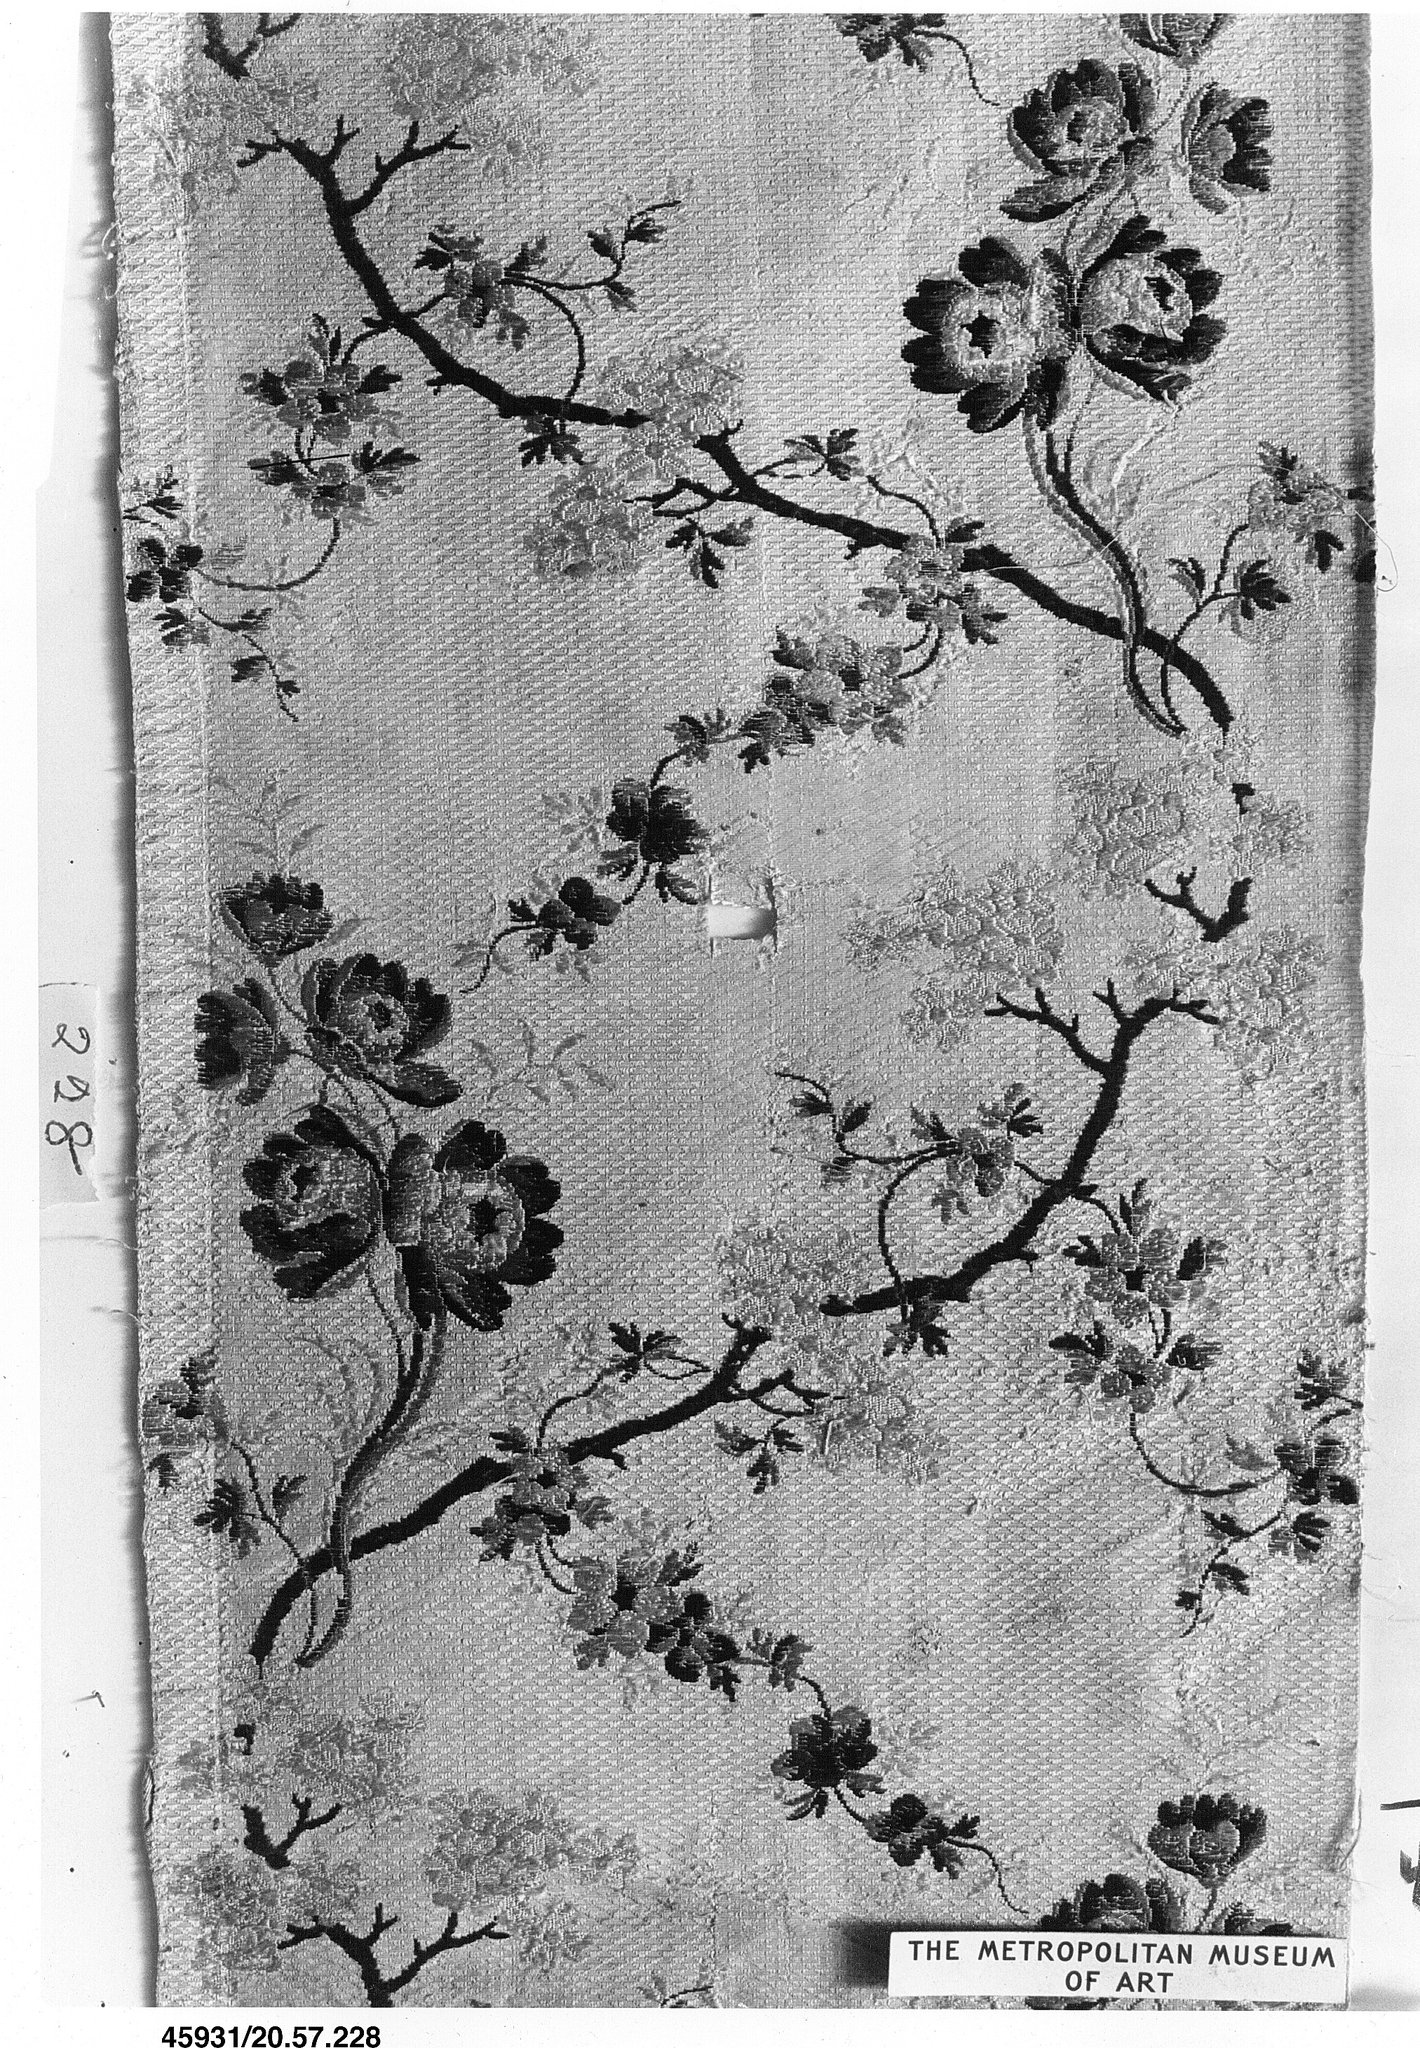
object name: piece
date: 1750-1760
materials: silk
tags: flowers,leaves